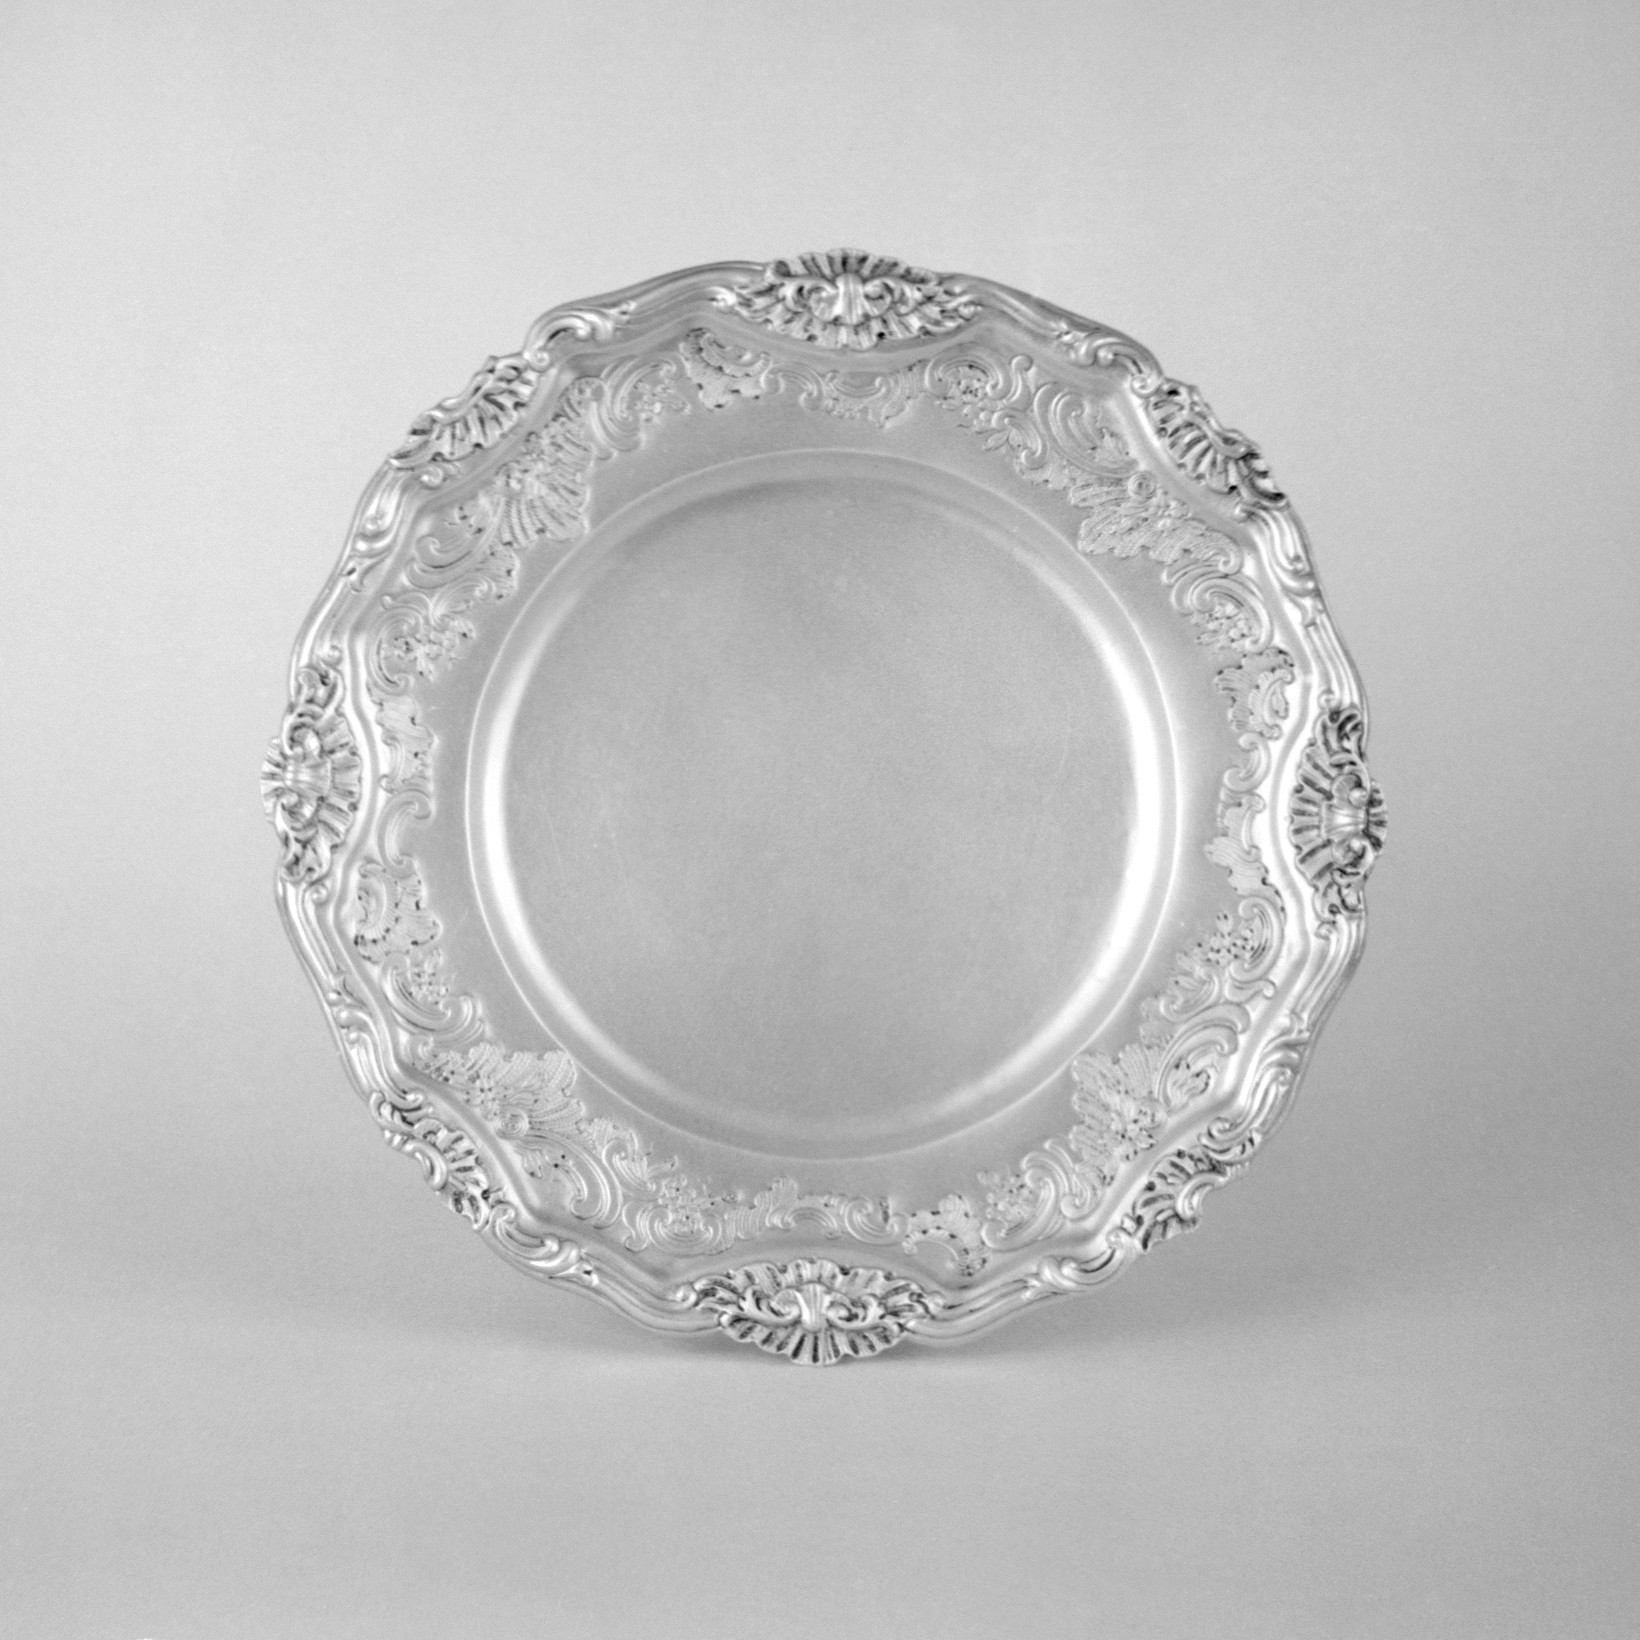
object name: plate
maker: gottlieb satzger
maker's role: maker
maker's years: 1709-1783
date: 1753-1755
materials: silver gilt